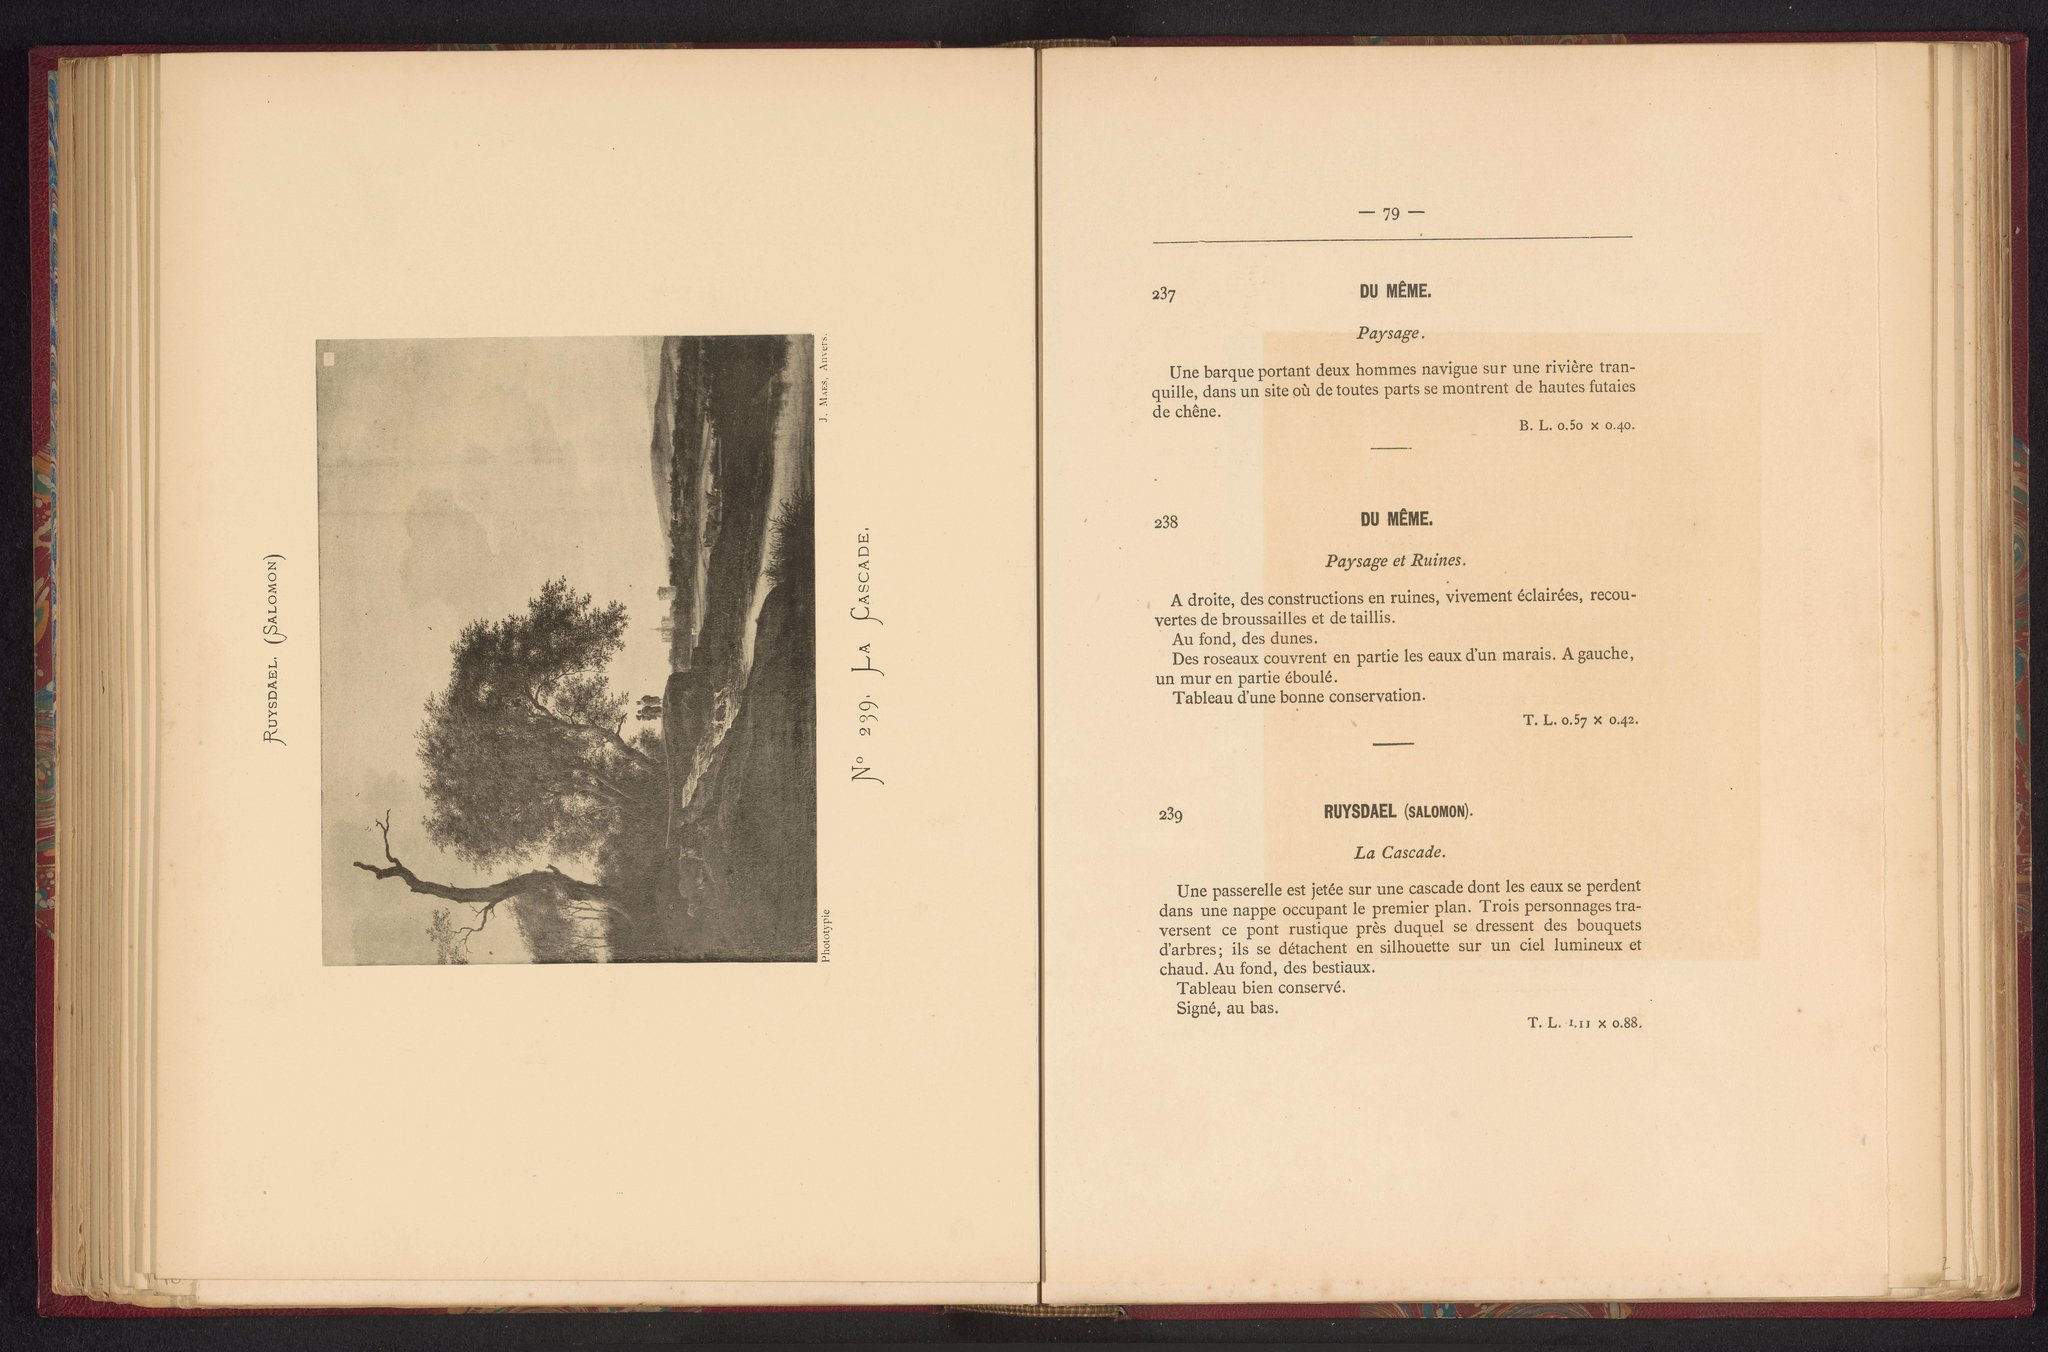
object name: photomechanical print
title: Ruysdael, Salomon - La cascade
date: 1878-1883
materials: paper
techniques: photograph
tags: landscapes with waters, waterscapes, seascapes (in the temperate zone), painting, drawing and the graphic arts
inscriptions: number: ‘No. 239’